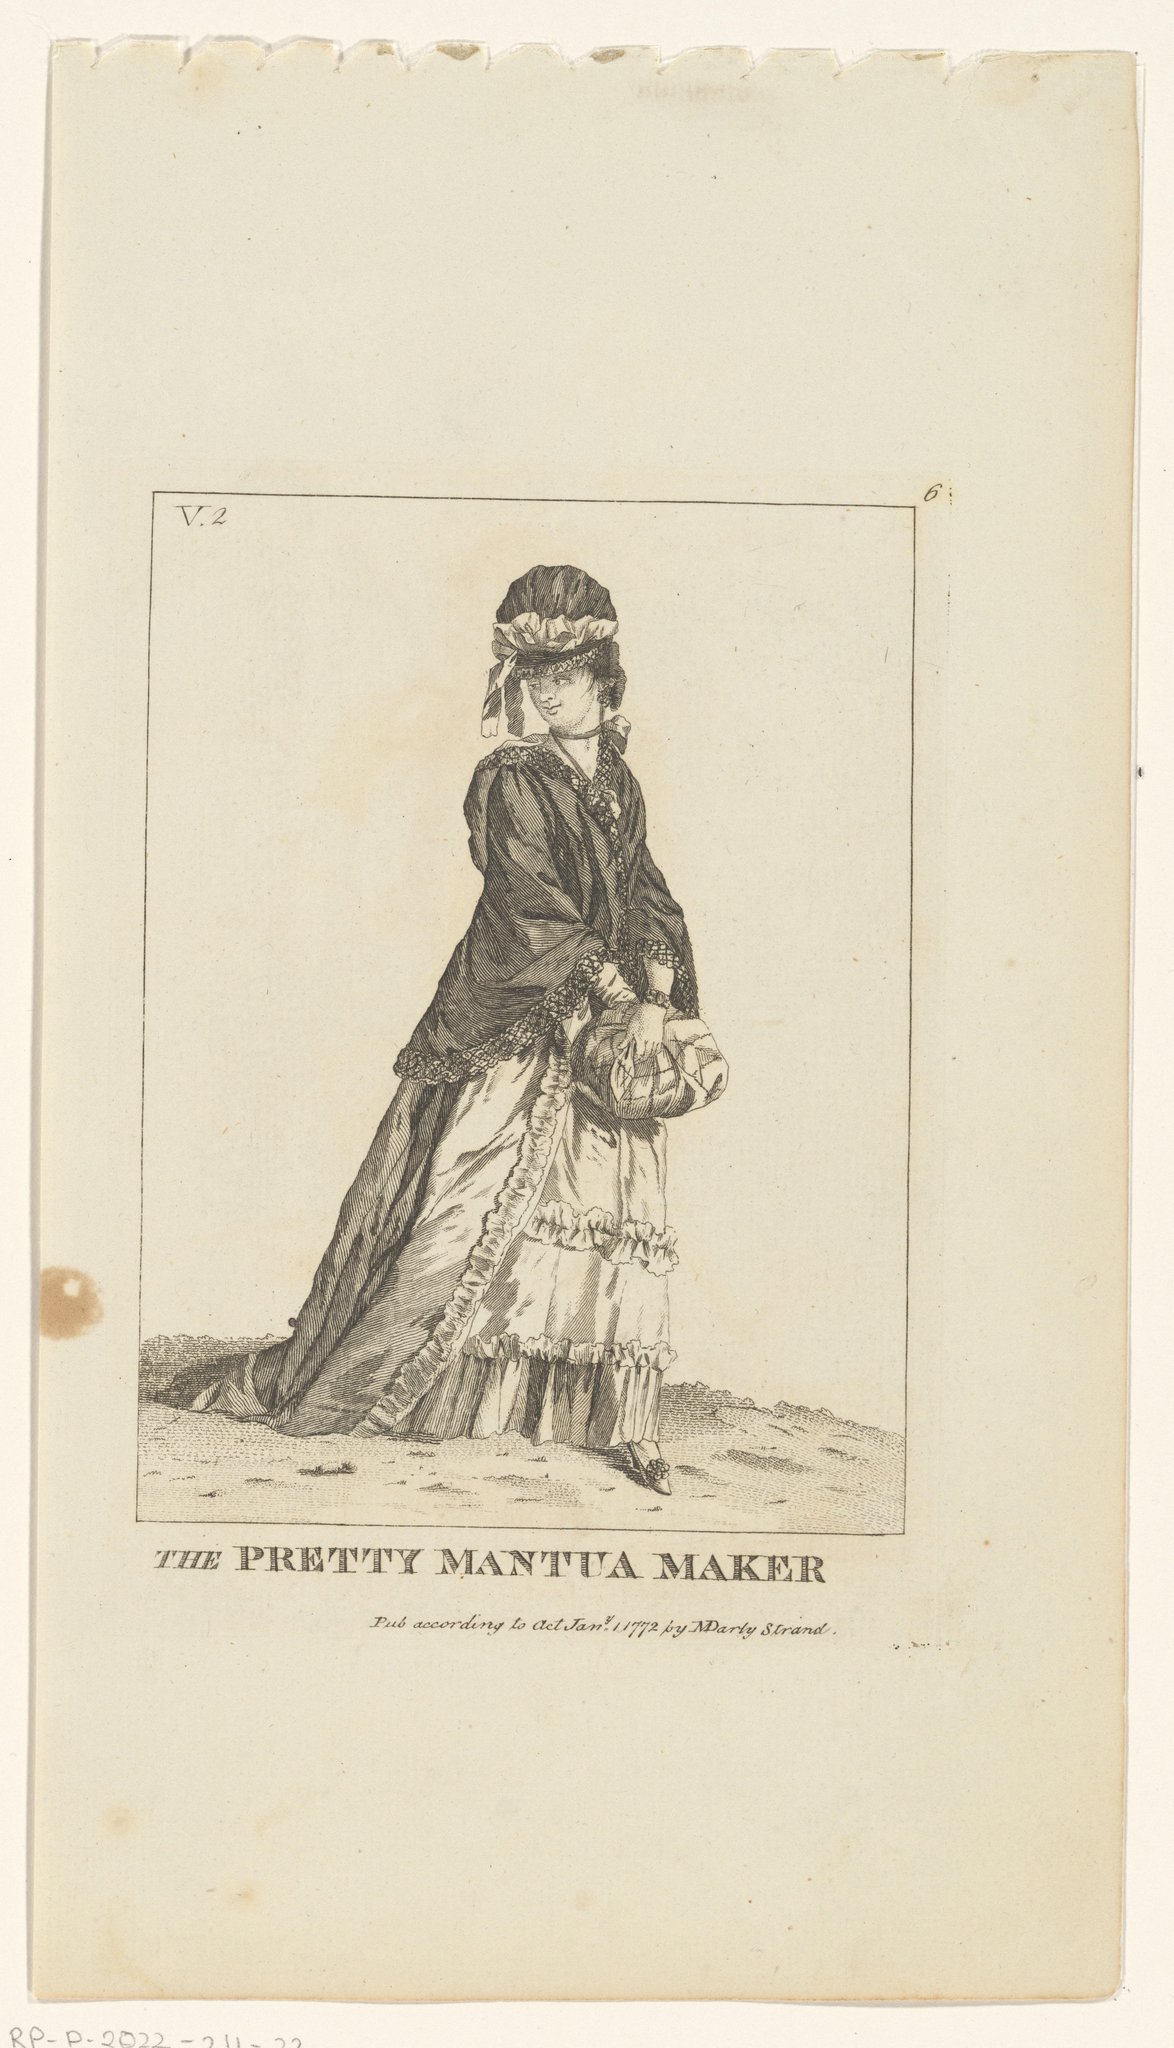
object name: print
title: The Pretty Mantua Maker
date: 1772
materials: paper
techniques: etching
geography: london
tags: caricatures (human types), tailor, dressmaker (+ women (labourers))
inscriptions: collector's mark: Lugt 2228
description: Een jonge vrouw (een kleermaakster) lopend naar rechts kijkt over haar rechterschouder naar beneden. Ze is elegant gekleed in een hoed met linten, een mantel en een lange rok met ruches. Prent nummer 6 uit de tweede van zes sets van elk 24 karikaturen van verschillende dames, heren, kunstenaars, enz., uitgegeven door de Darly’s.